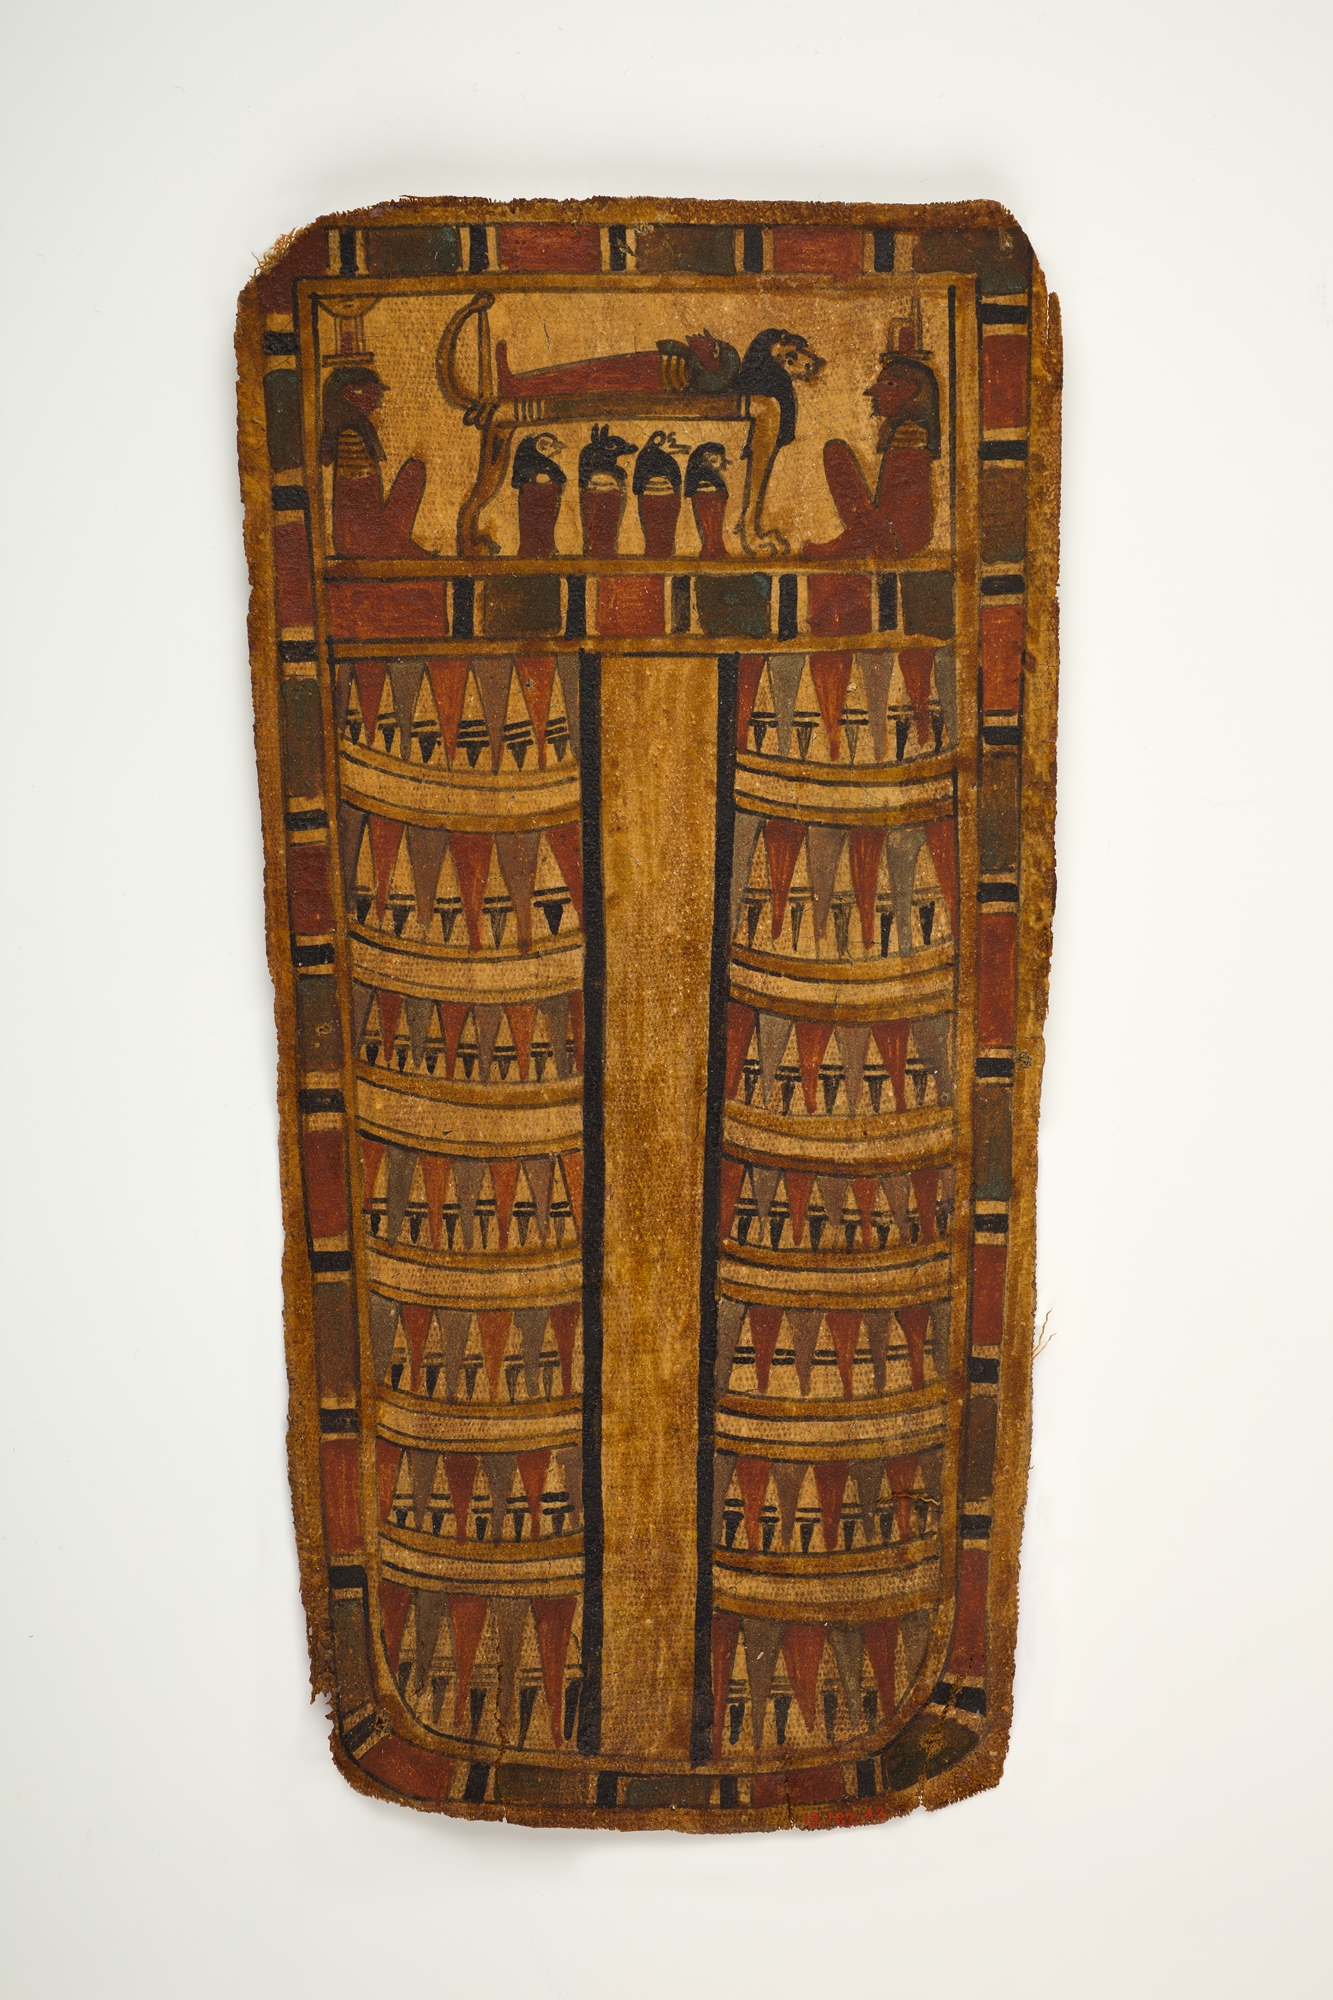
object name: cartonnage fragment, painted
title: Cartonnage fragment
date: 100-300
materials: linen, paint, plaster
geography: egypt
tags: human figures,animals